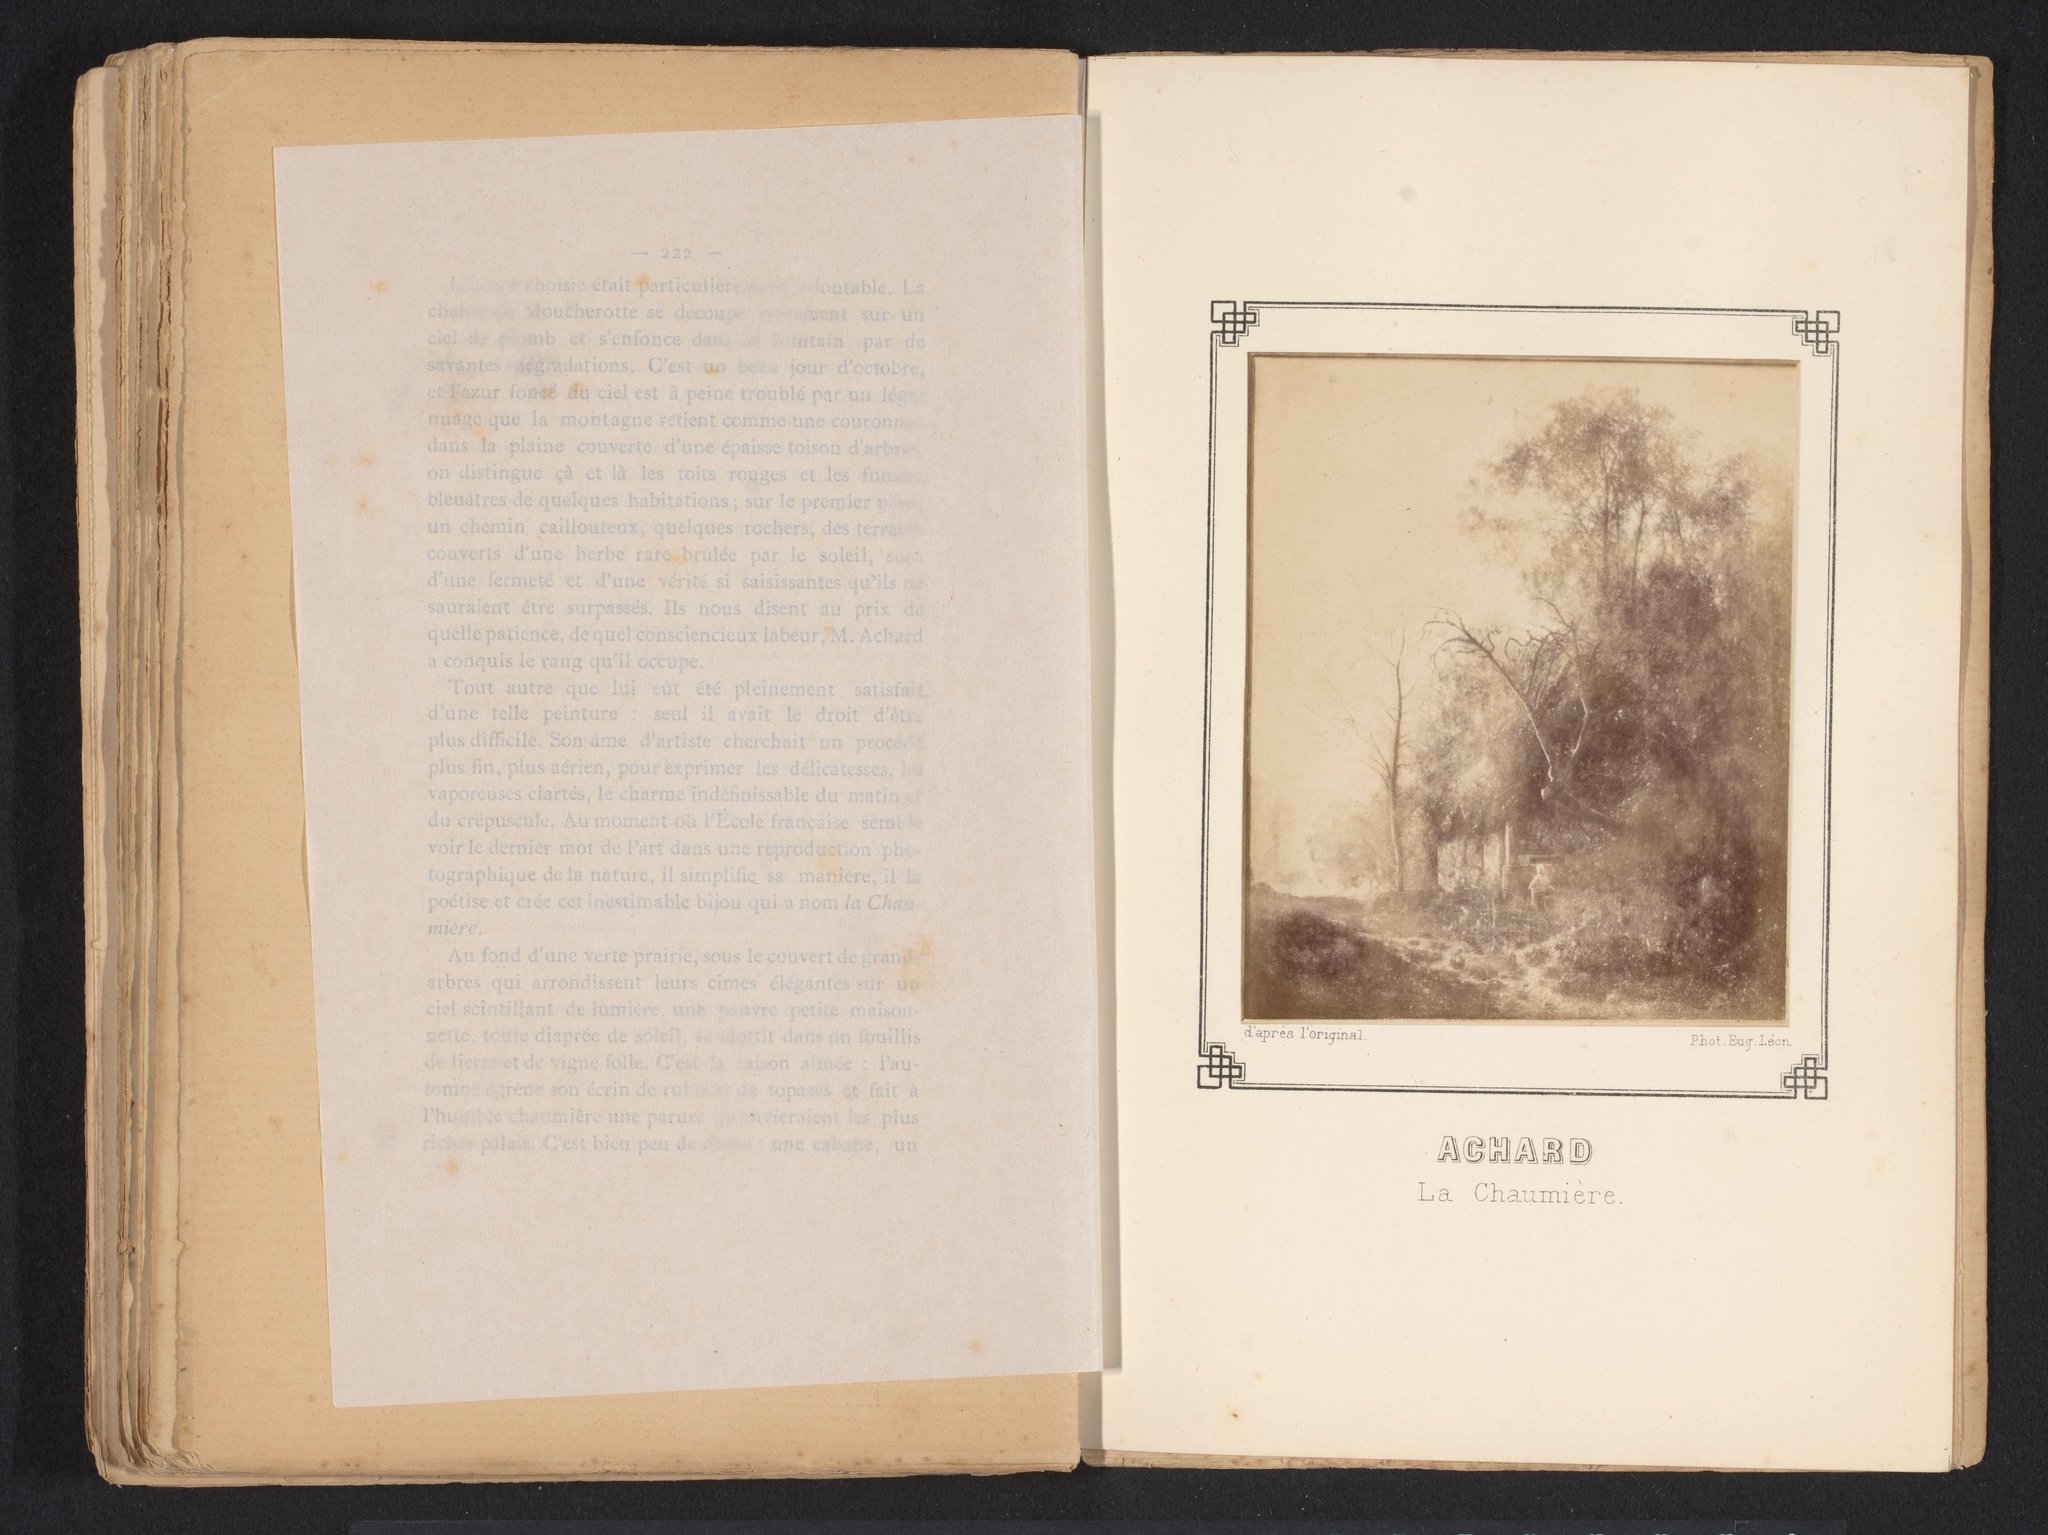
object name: photograph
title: Fotoreproductie van een schilderij van een landschap met een dode boom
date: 1869-1879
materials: photographic support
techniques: albumen print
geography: grenoble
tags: landscapes, picture, painting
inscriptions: inscription: ‘d'après l'original.’